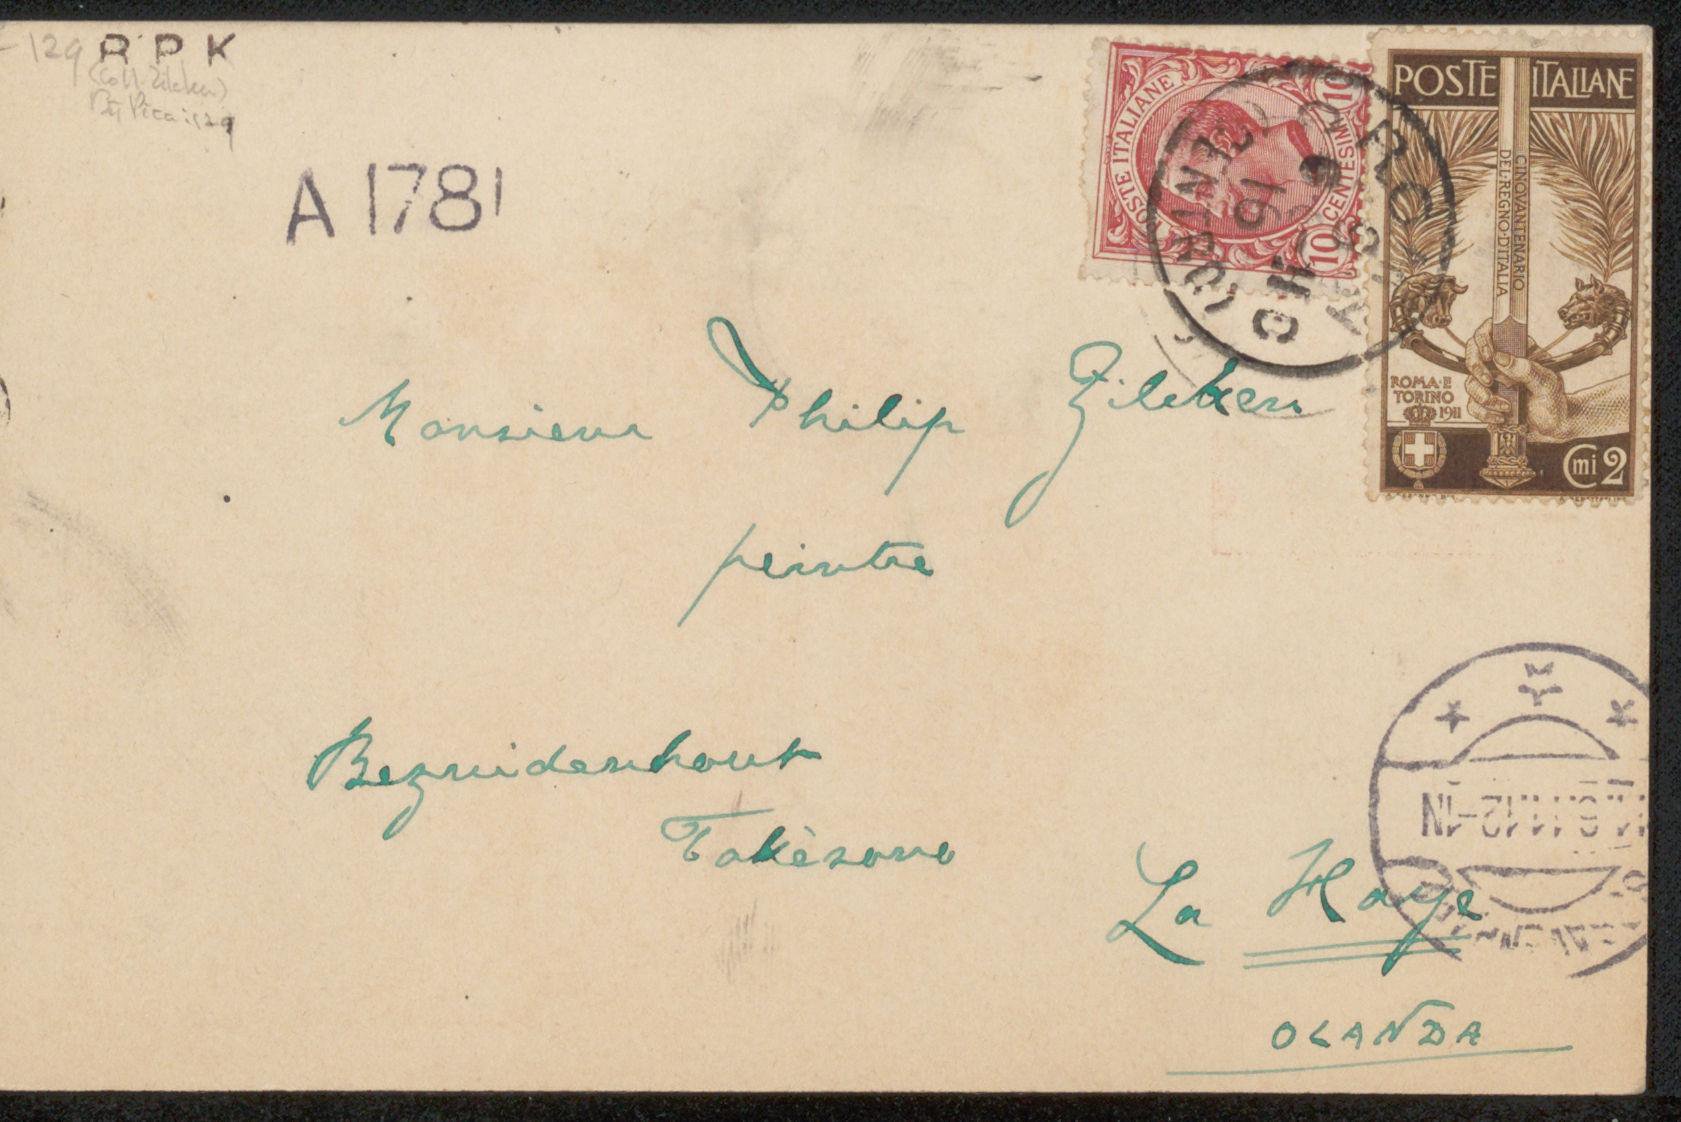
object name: letter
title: Brief aan Philip Zilcken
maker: vittorio pica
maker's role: criticus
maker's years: 1864-1930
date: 1911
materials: cardboard, ink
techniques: pen, printing, writing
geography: rome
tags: painter, draughtsman, philip zilcken, exhibition ~ art, the hague, rome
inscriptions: collector's mark: ‘RPK’